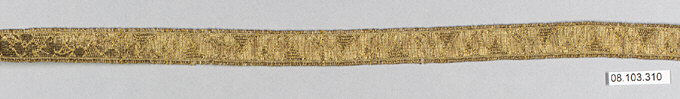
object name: galloon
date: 1601-1800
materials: silk